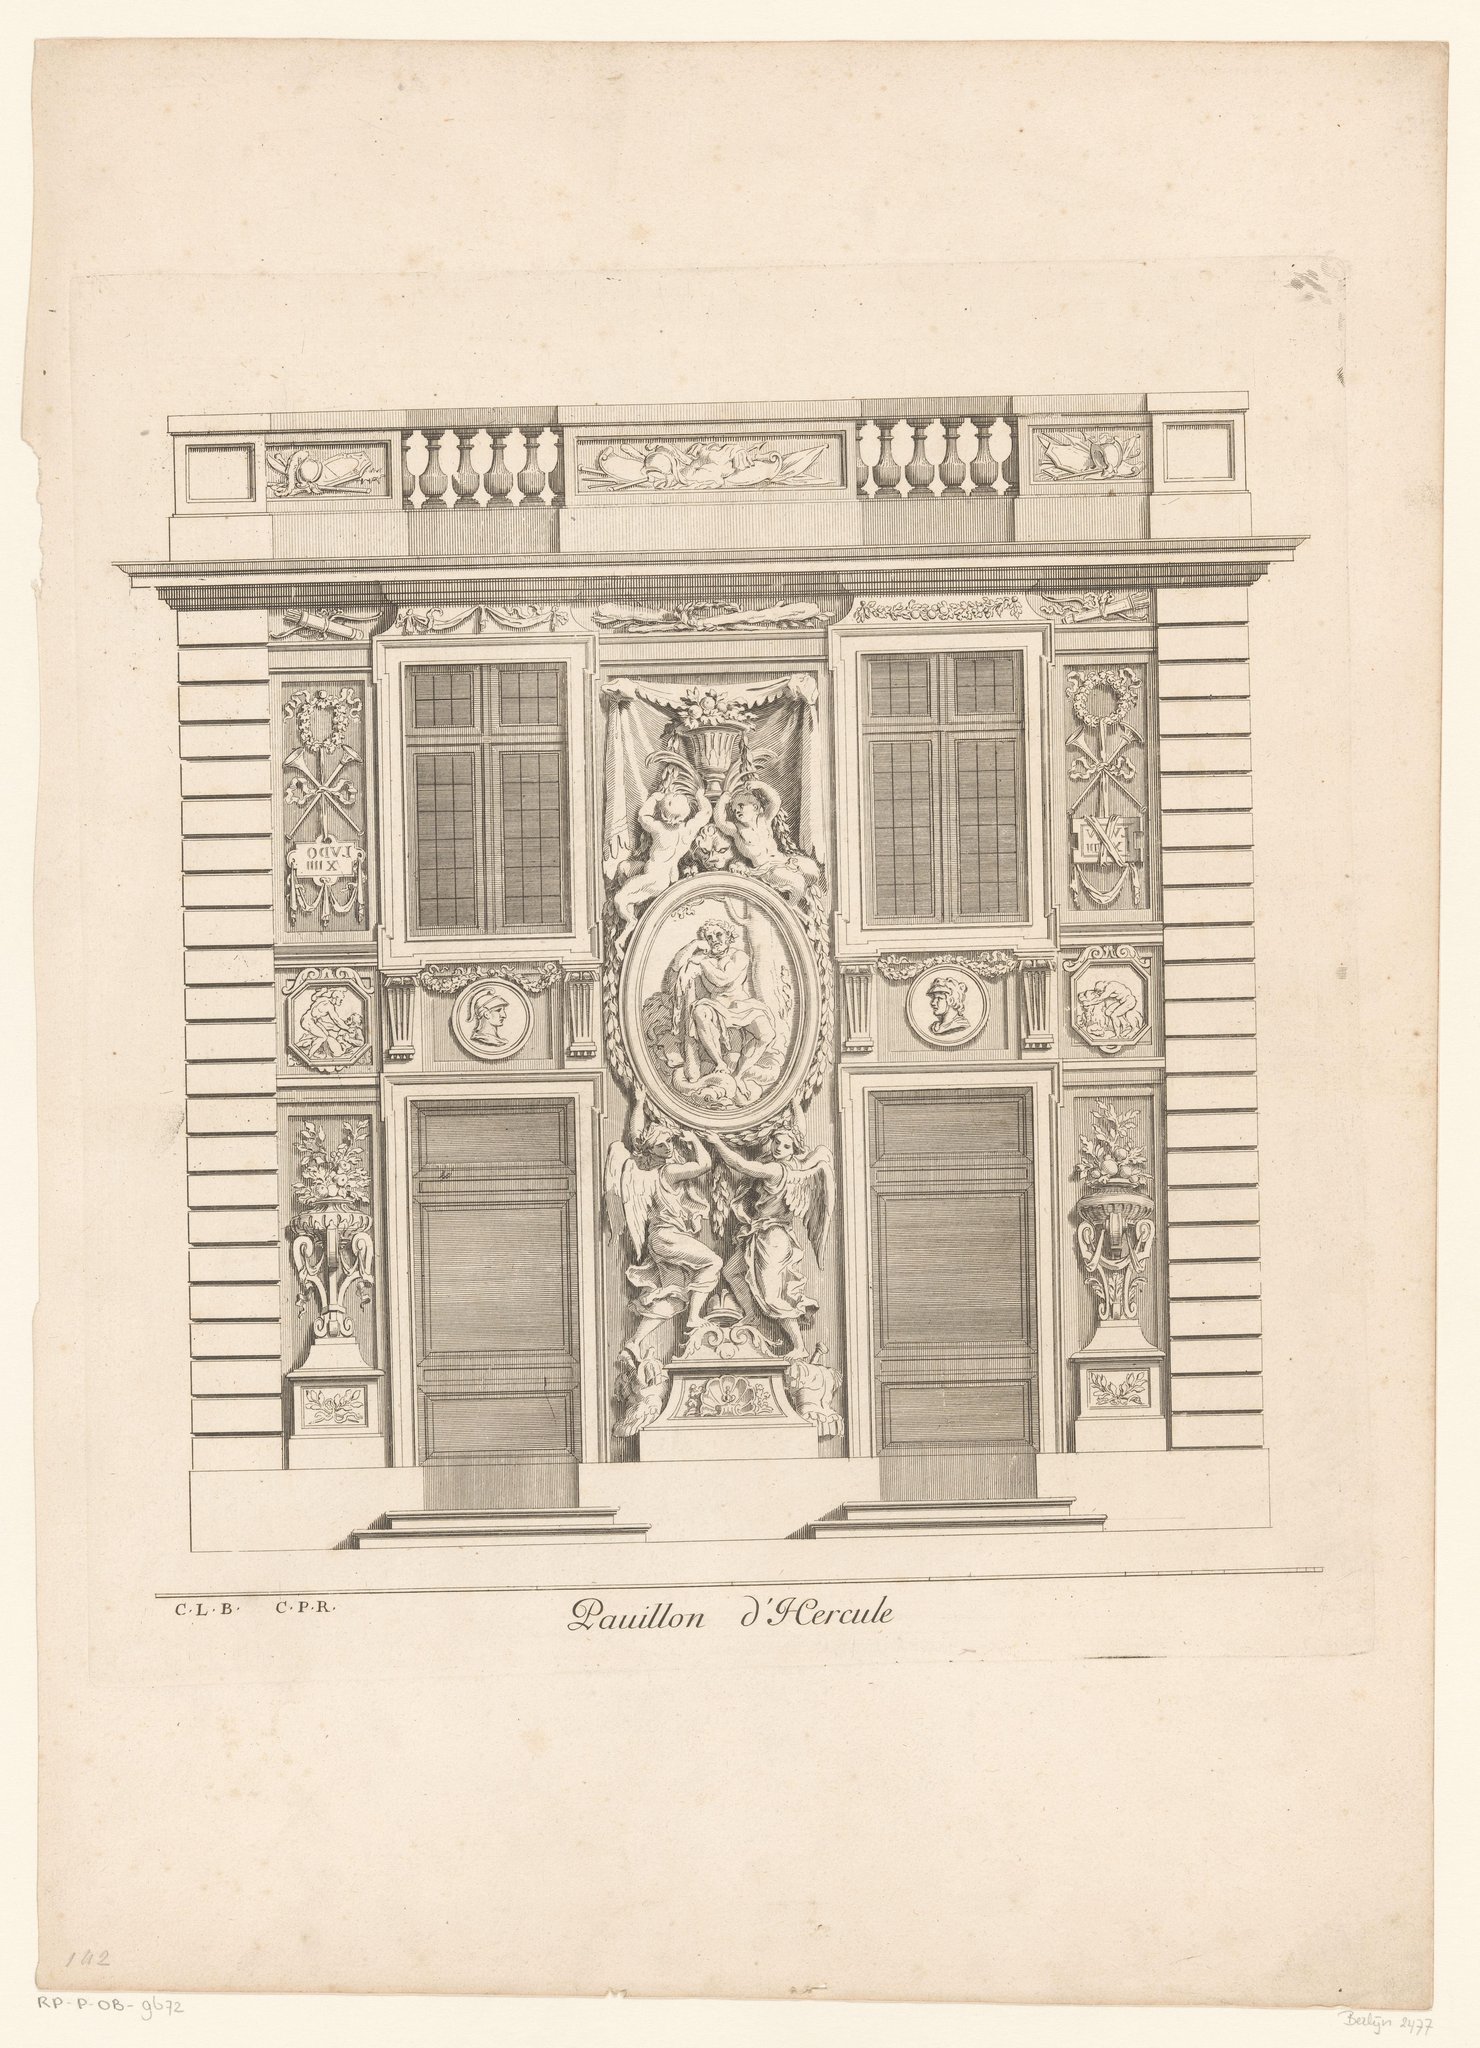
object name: print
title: Paviljoen van Hercules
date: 1672-1686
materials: paper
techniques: etching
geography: paris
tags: (story of) hercules (heracles), façade (of house or building)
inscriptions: collector's mark: Lugt 2228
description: Façade van een paviljoen met trofeeën, vazen op driepoten, medaillons met portretten, een medaillon met Hercules gedragen door engelen en een balustrade aan de bovenzijde.